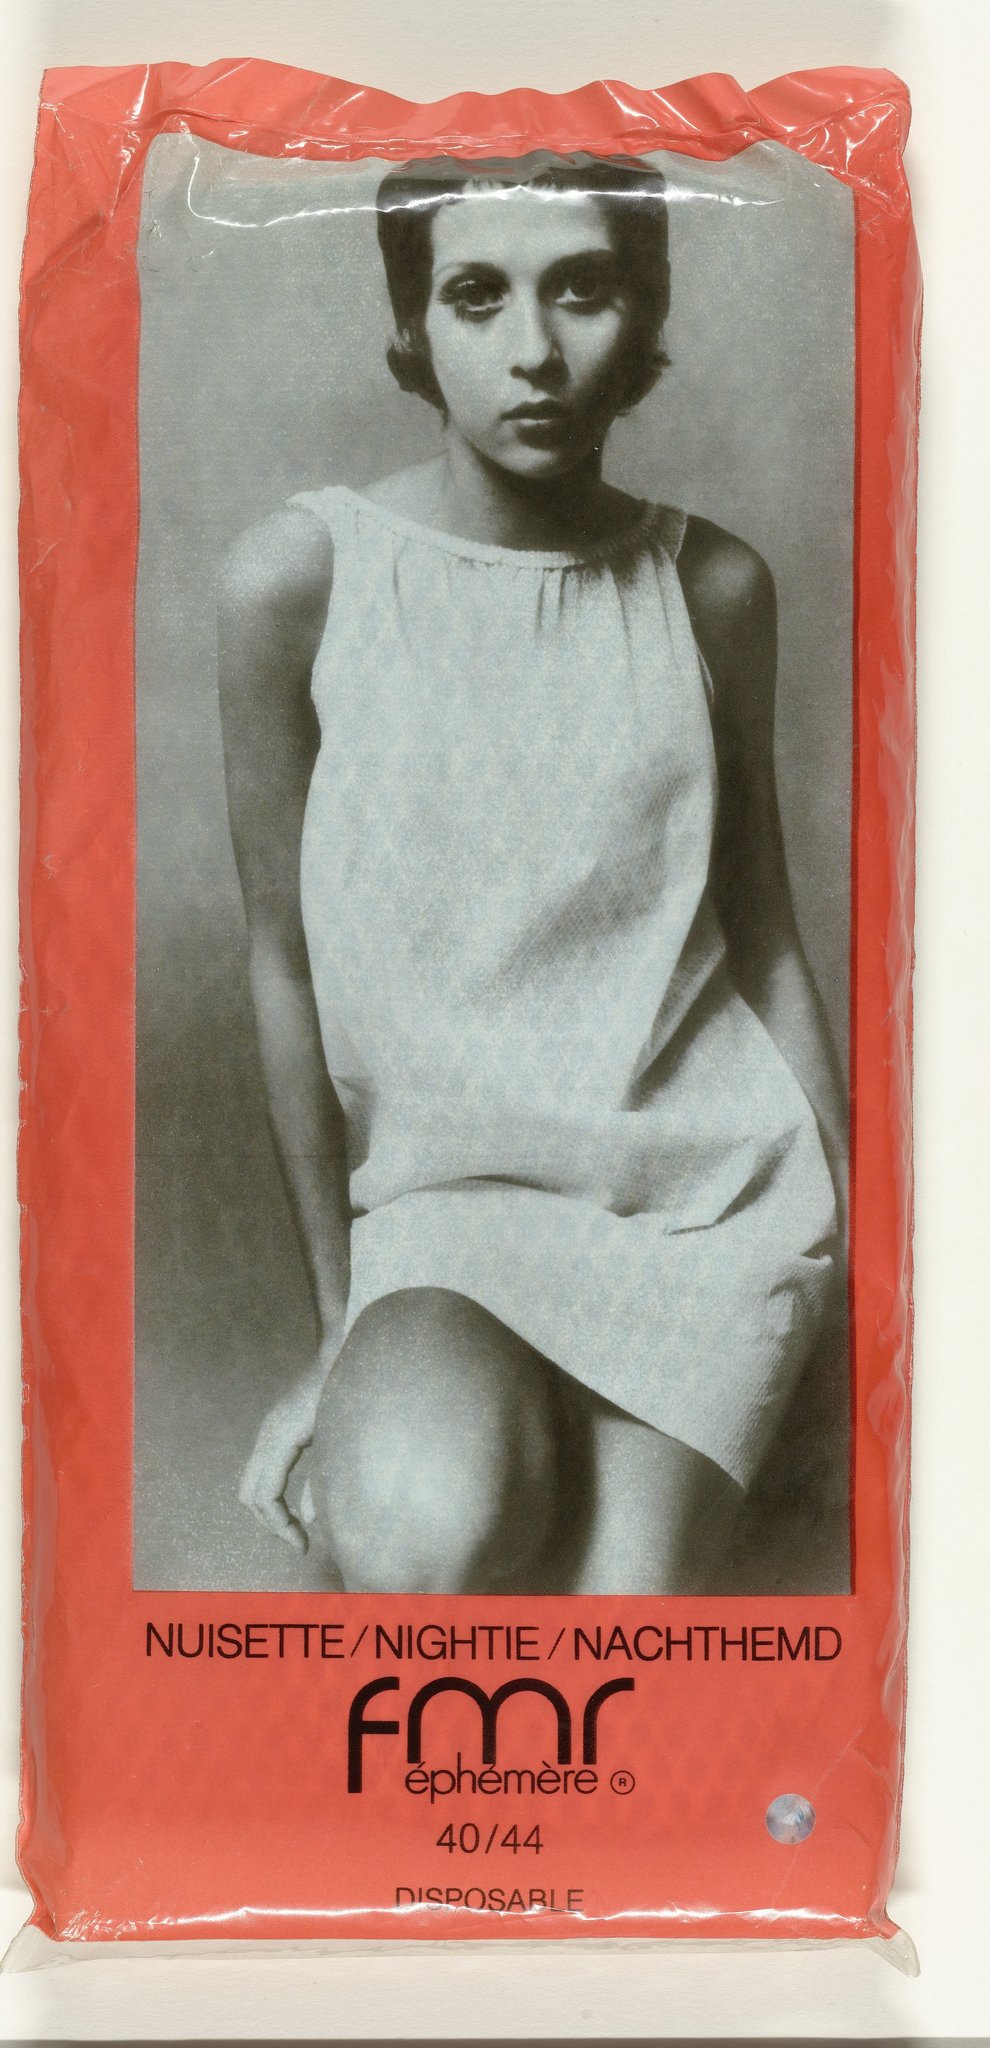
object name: nightshirt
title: Wegwerp nachthemd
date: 1970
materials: acrylic, plastic, textile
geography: france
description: Wegwerp nachthemd, maat 40/44. De pon is lichtblauw met wit, soort wybertjespatroon, met een elastiekje bij de hals, zonder mouwen en op knielengte. In originele gesloten plastic verpakking met een rode rand. Hierin een foto van een vrouw in dit nachthemd. Achterzijde doorzichtig. Op voorkant opschrift: Nuisette, Nightie, Nachthemd. FMC éphémère. 40/ 44. Disposable. Op achterzijde: All through the week it is more covenient! While travelling during holidays at the hotel, no more washing! Leave it to FMC (tekst ook in het Frans, Duits en Italiaans).